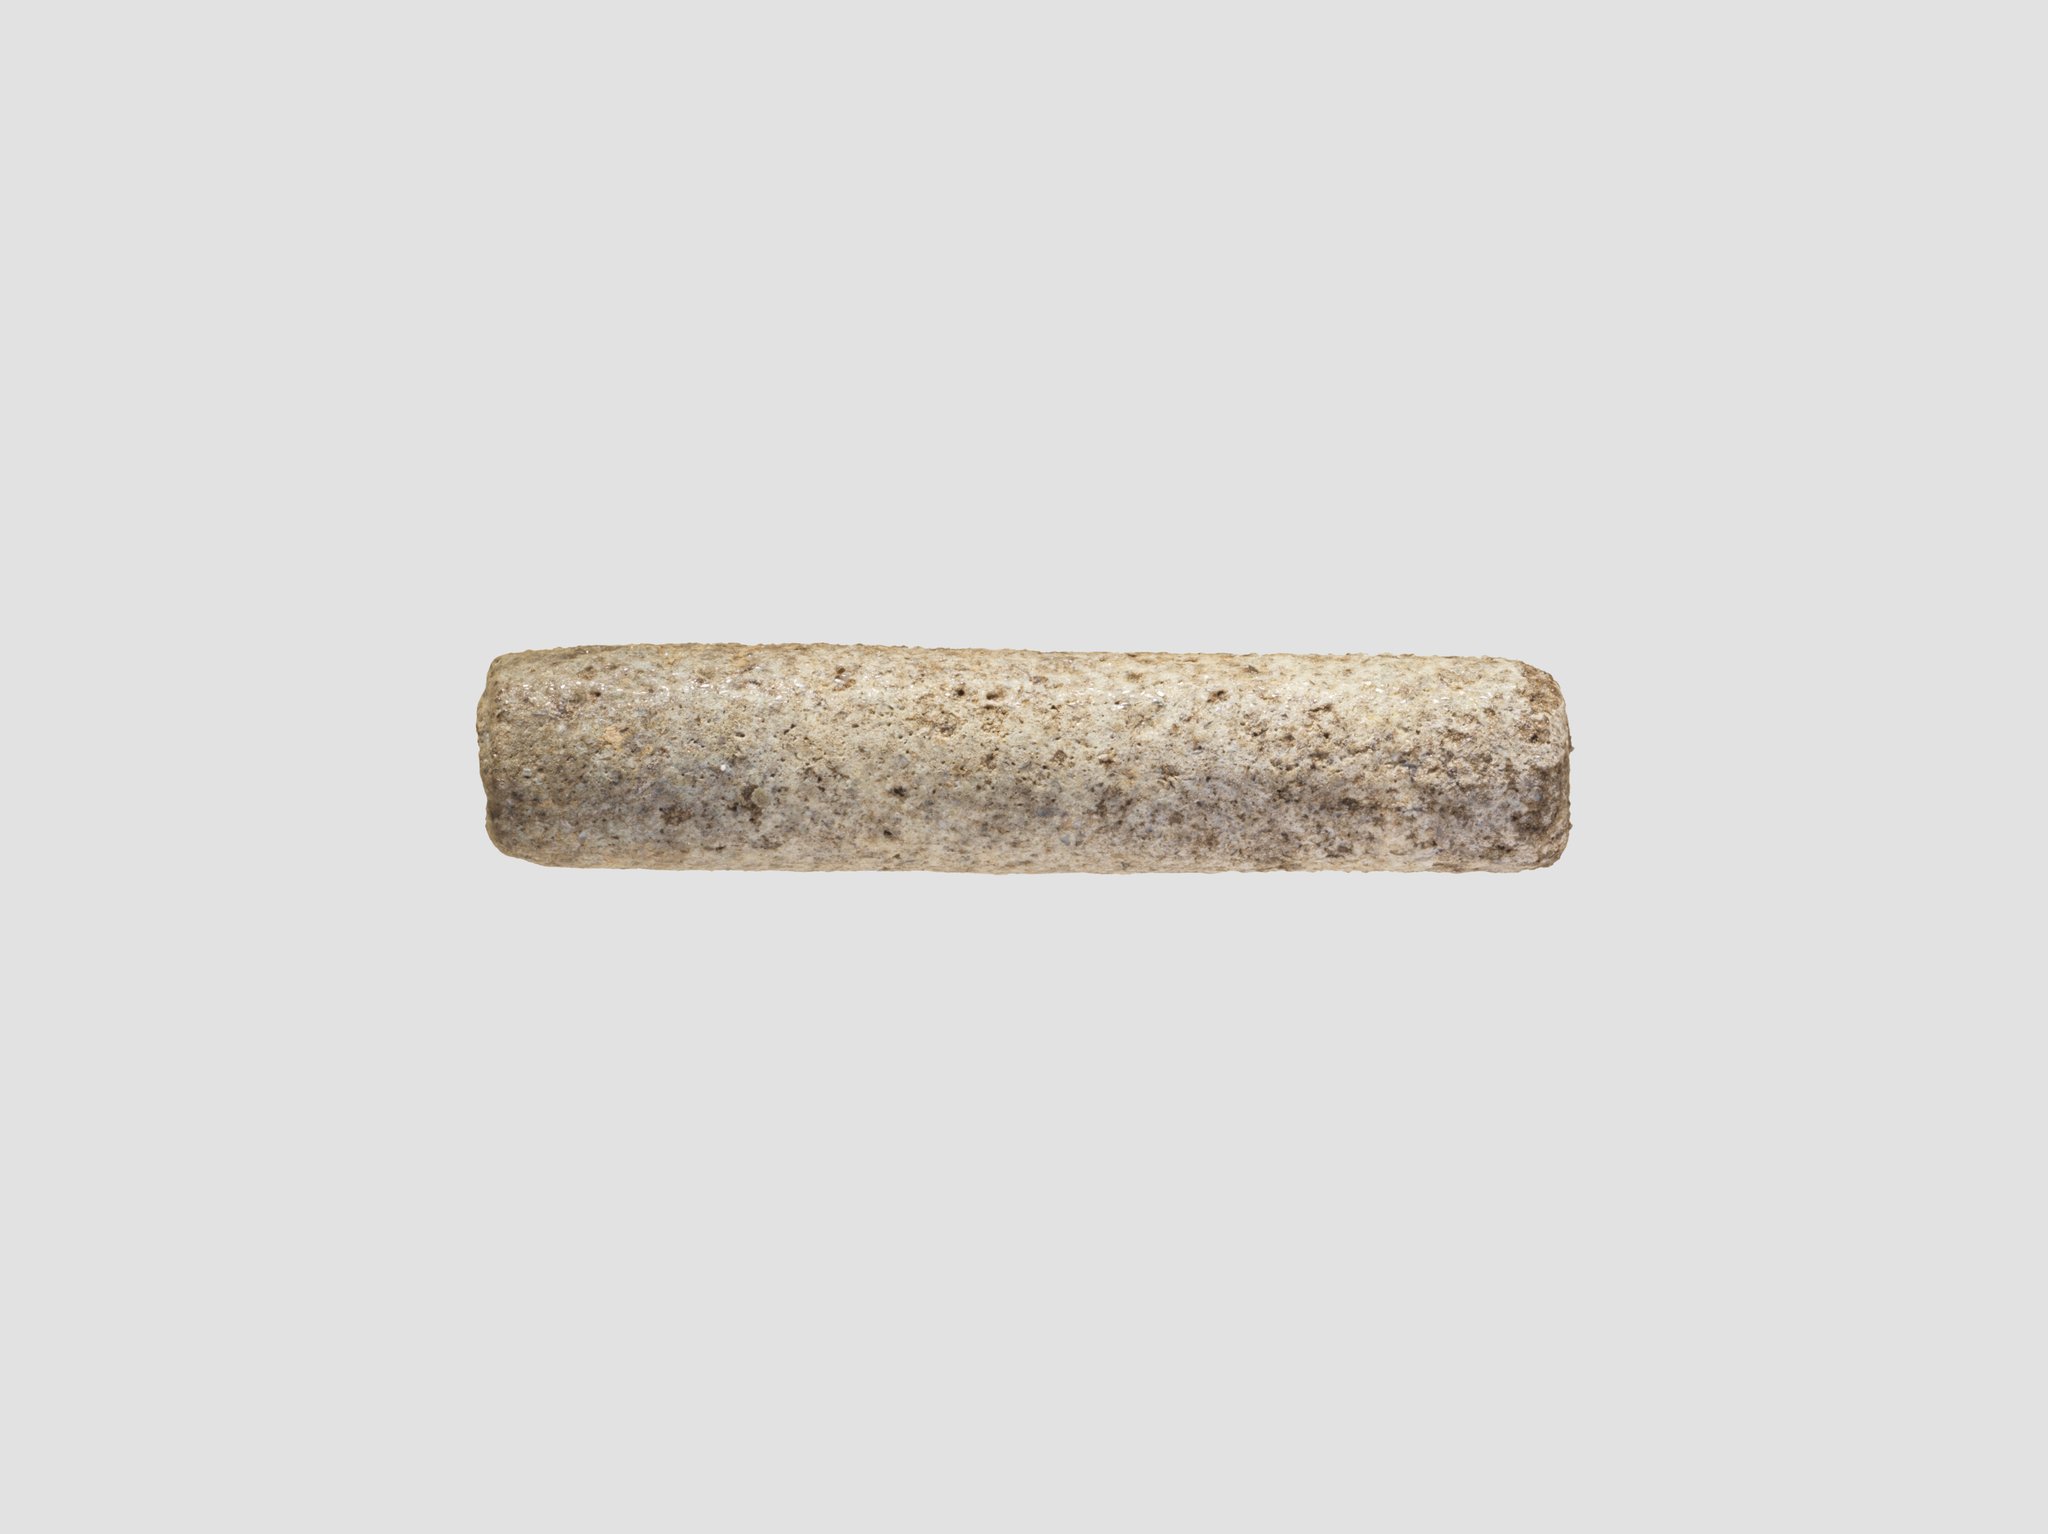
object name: ornament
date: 2333-2001 BCE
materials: faience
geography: mesopotamia